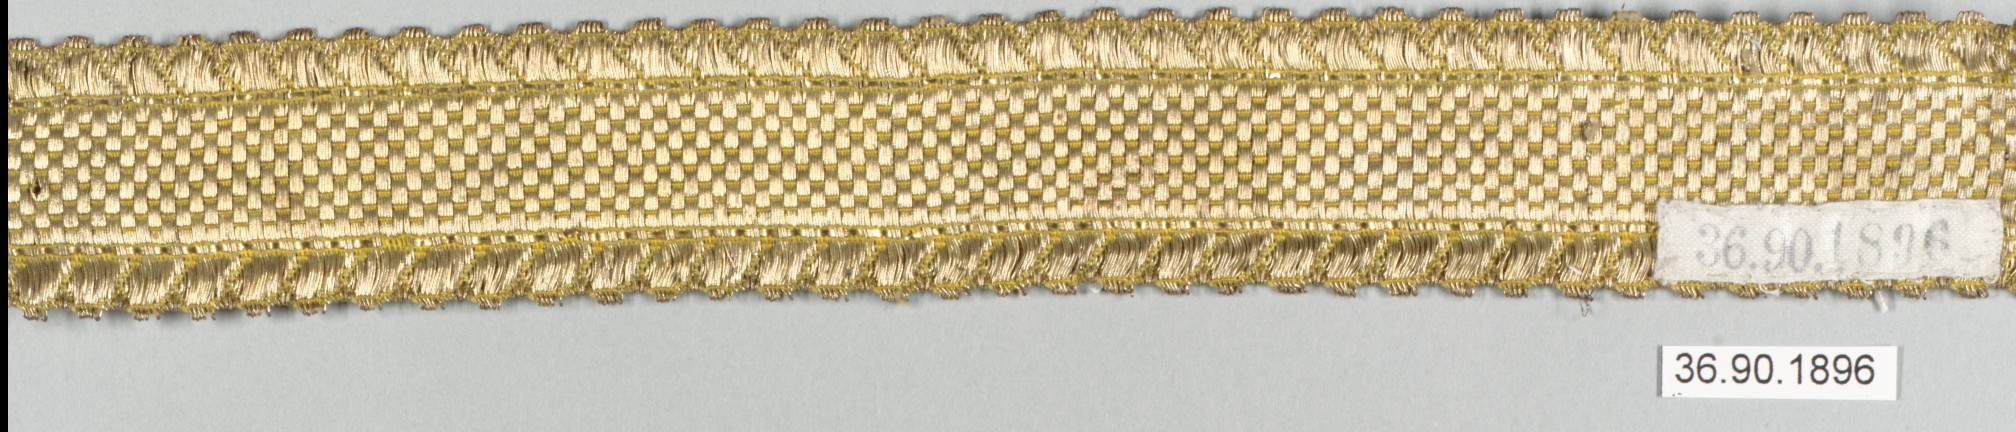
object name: galloon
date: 1801-1900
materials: cotton, metal thread